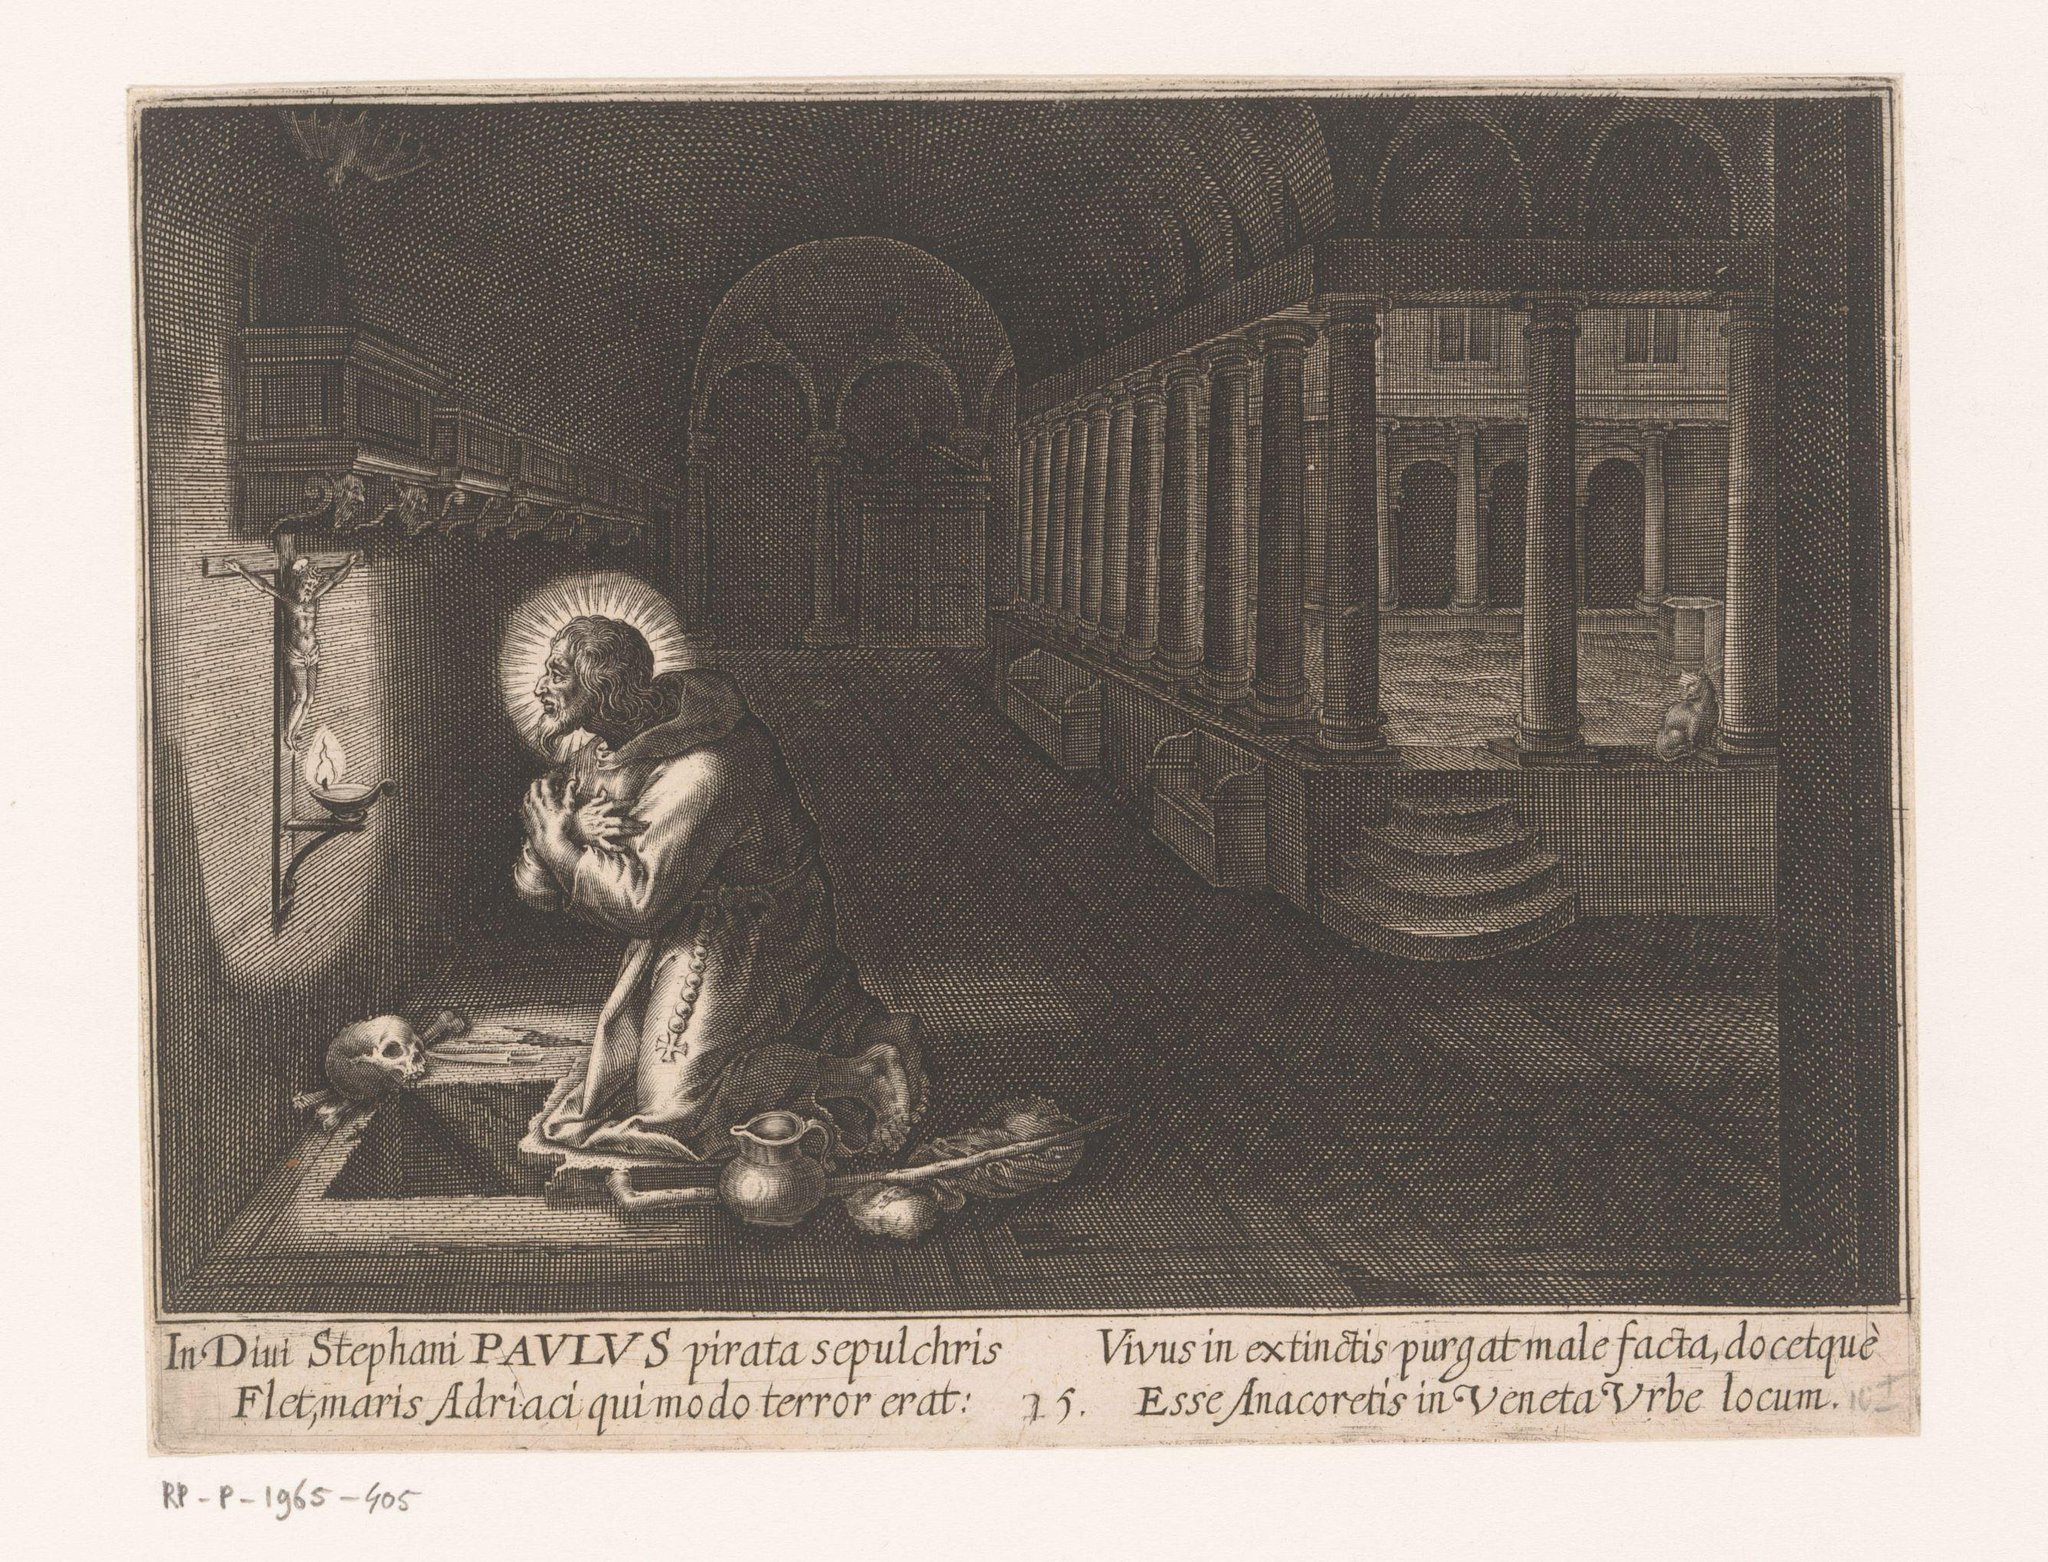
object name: print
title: Heilige Paulus biddend bij een graf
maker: thomas de leu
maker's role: print maker, publisher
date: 1598-1614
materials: paper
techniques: engraving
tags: abbey, monastery, convent ~ roman catholic church, grave, tomb, anchorite, hermit, one person praying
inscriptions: collector's mark: Lugt 2228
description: Maakt deel uit van een 24-delige serie met titelprent, over het leven van kluizenaars en heremieten naar prenten van Johann (I) en Raphaël Sadeler (I), naar ontwerp van Maerten de Vos en uitgegeven door Thomas de Leu. Dit betreft prent 15 uit de serie, maar in de oorspronkelijke serie betrof dit prent 25.